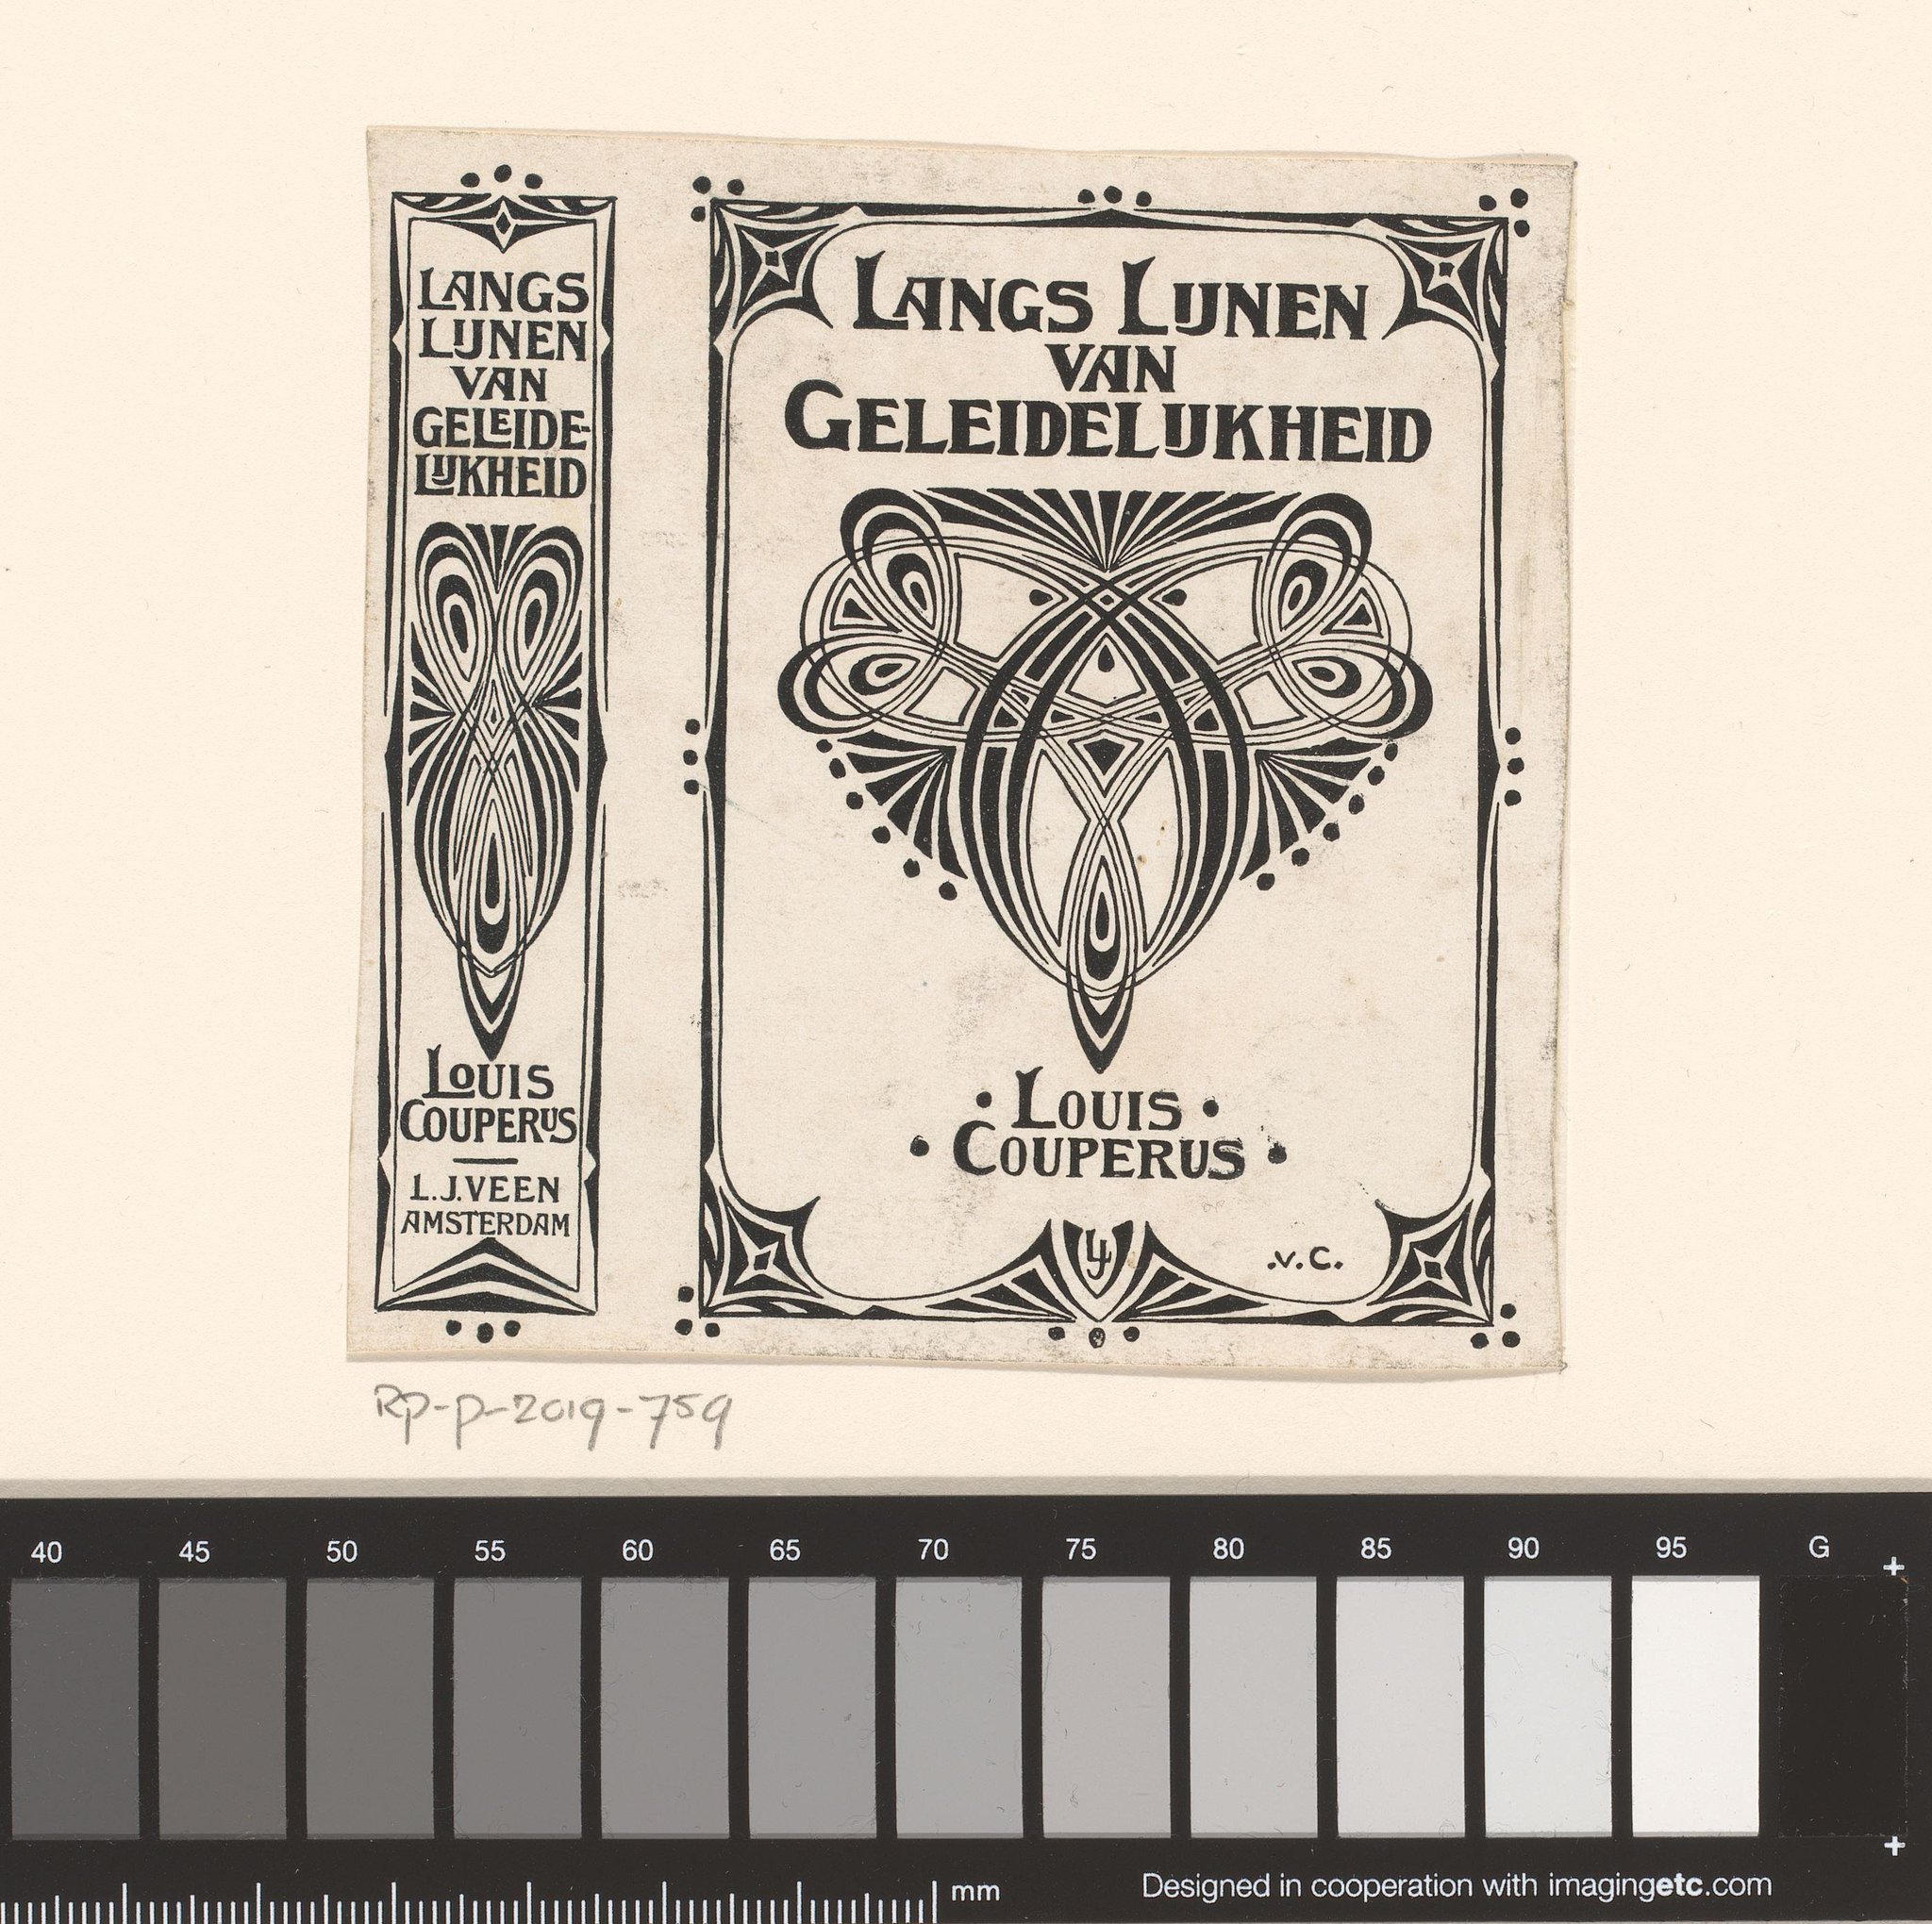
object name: photomechanical print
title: Bandontwerp voor: Louis Couperus, Langs lijnen van geleidelijkheid, 1900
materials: paper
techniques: photochemical processes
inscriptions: collector's mark: Lugt 2228a